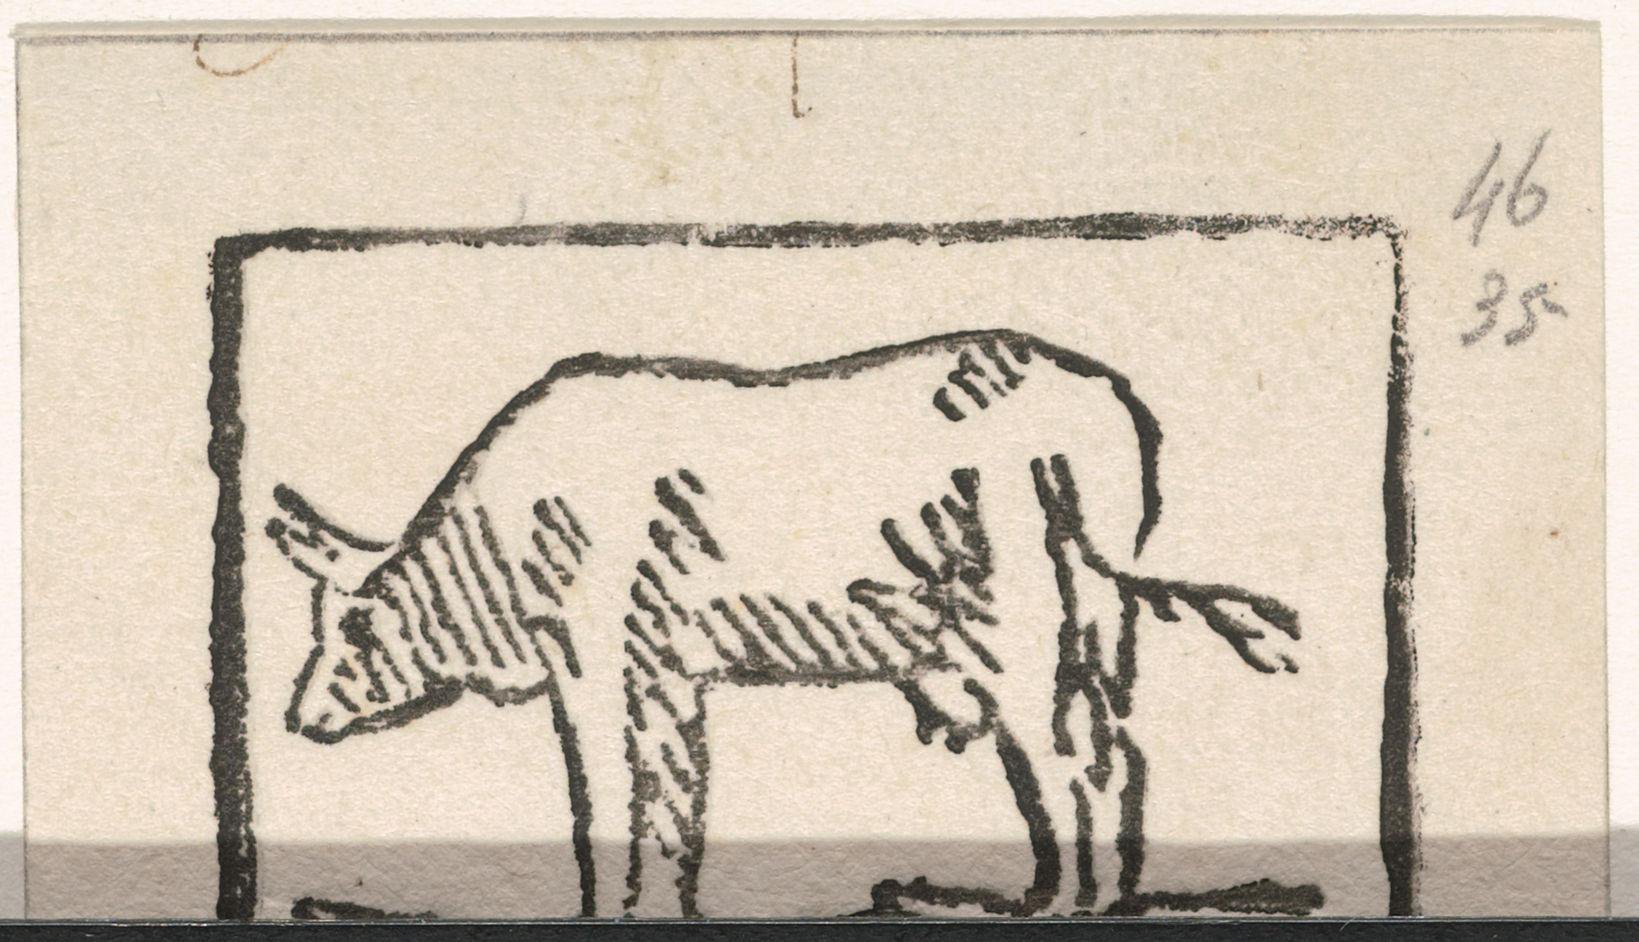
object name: print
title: Jongen met een slaapmuts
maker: vincent van der vinne van lee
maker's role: print maker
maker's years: 1798-1876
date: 1808-1876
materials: paper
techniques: woodcut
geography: haarlem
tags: nightwear: night-cap